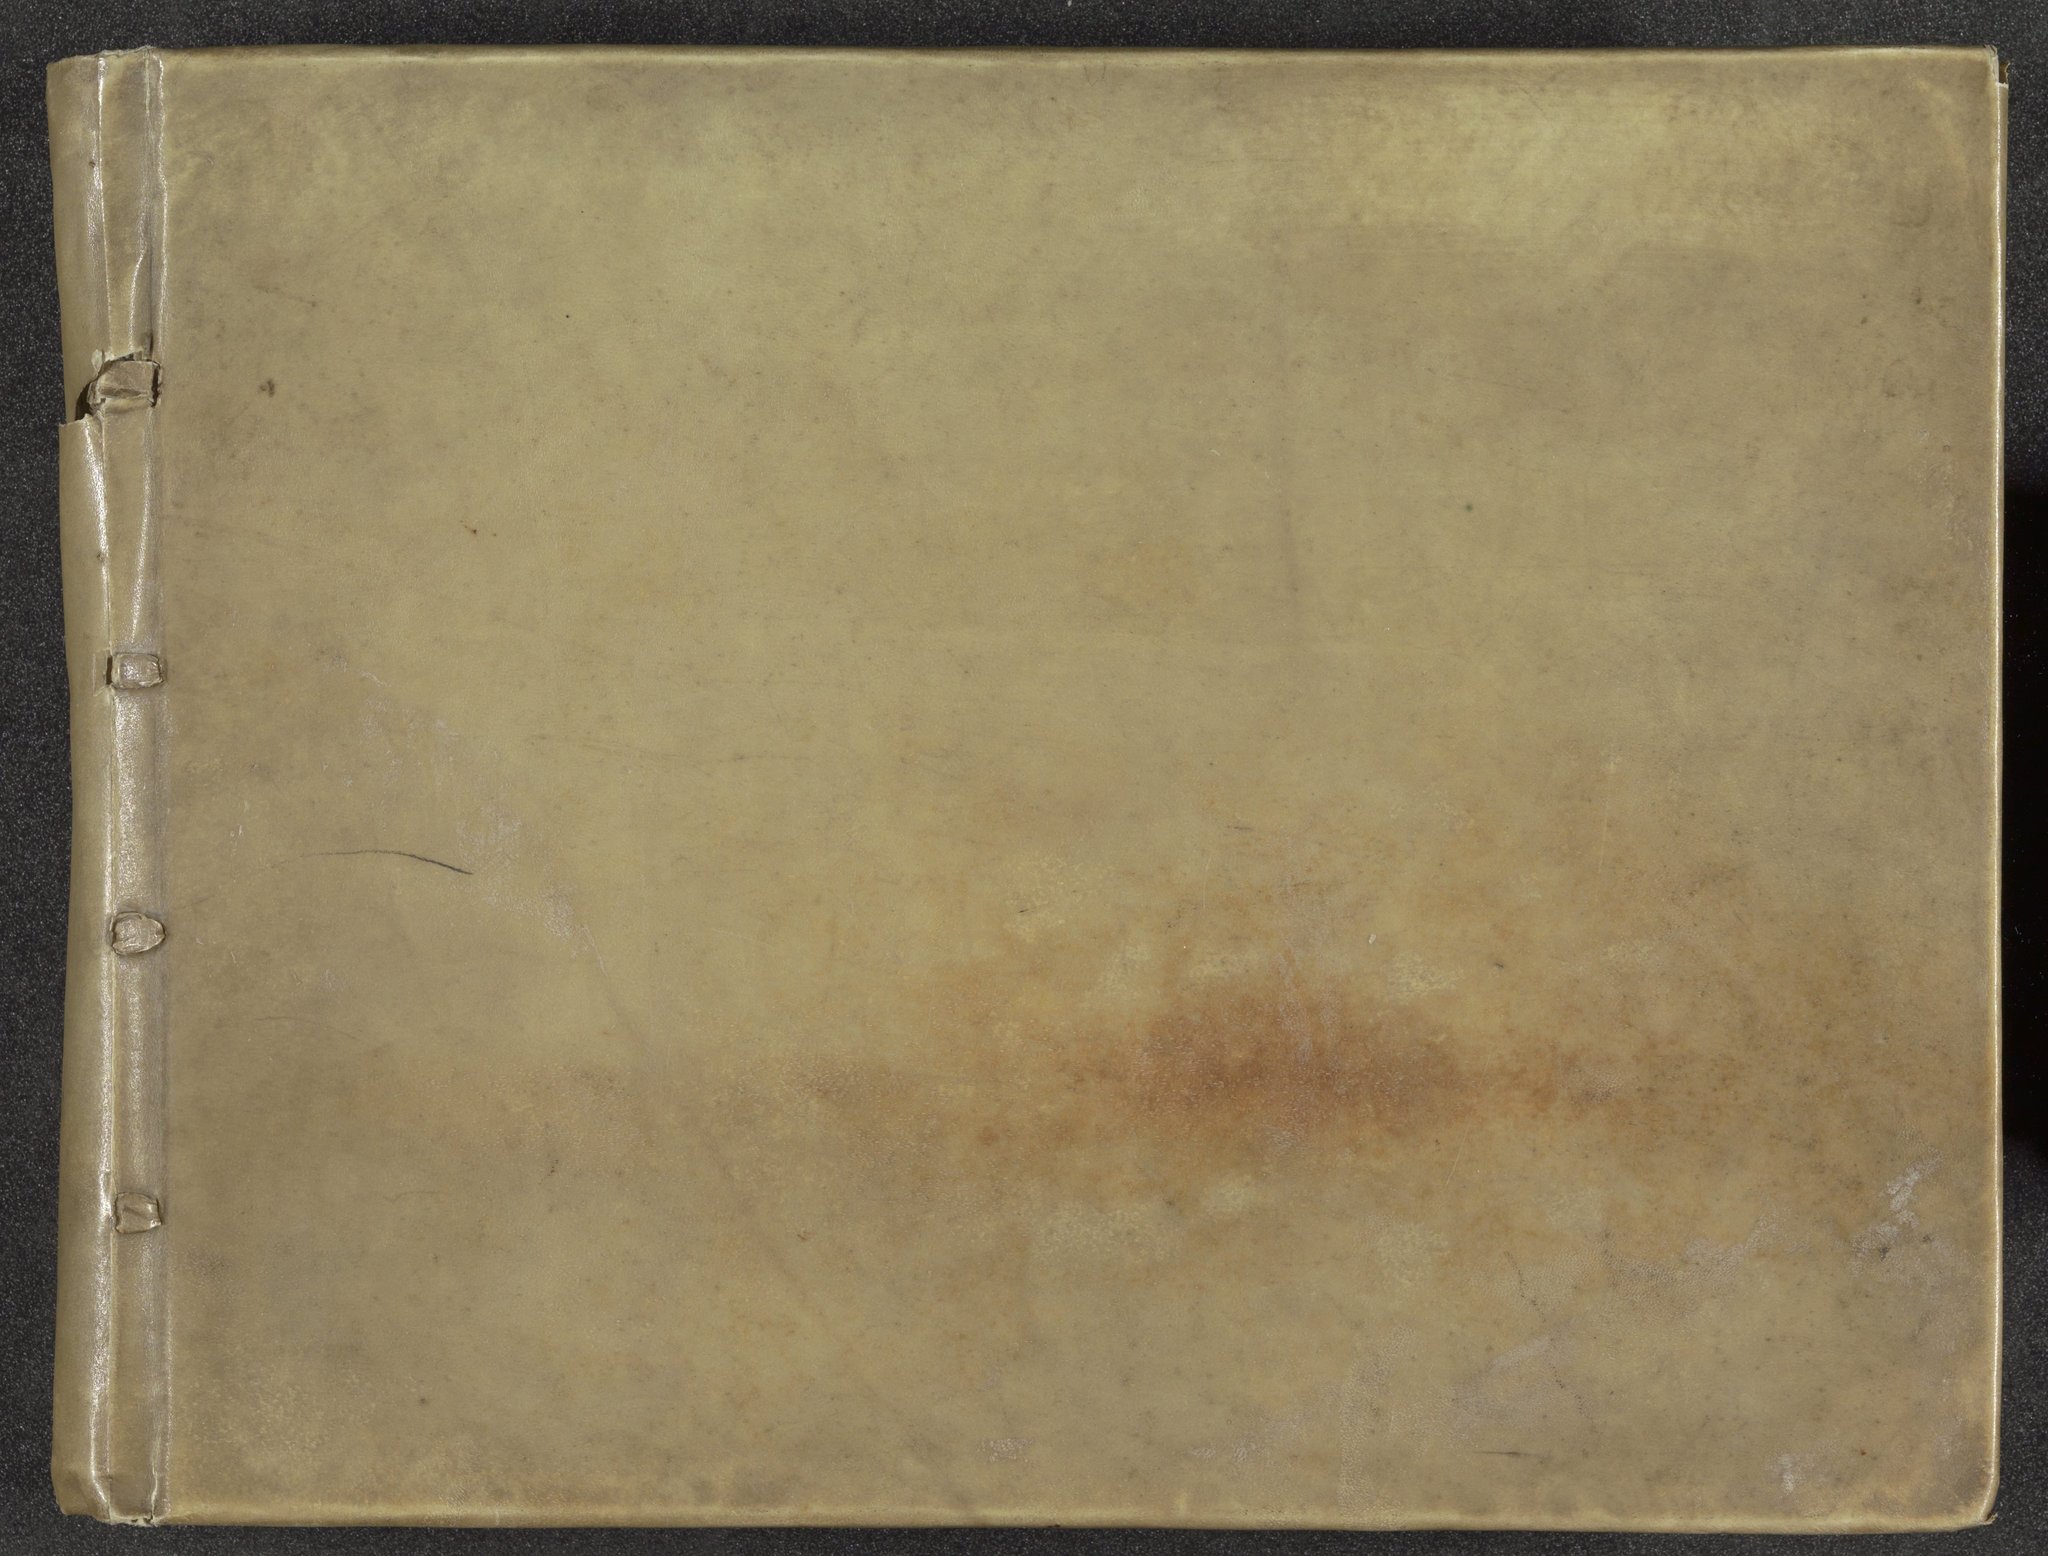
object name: prentrecueil, prentenalbum, prentalbum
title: Verzamelaarsalbum met houtsneden van Christoffel van Sichem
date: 1740-1808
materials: paper, parchment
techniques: bookbinding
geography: antwerp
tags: new testament, old testament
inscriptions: collector's mark: Lugt 2166, inscription: ‘15/ C. 10’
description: Verzamelaarsalbum met 750 opgeplakte houtsneden en 2 typografische titelpagina's op 135 blauwe albumbladen. Daarbij twee houtsneden los in het album. Het betreffen voornamelijk boekillustraties van Christoffel (II) en Christoffel (III) van Sichem, afkomstig uit publicaties van Jacob Pietersz Paets en Jan Klooster. Vooral bij Paets werden de houtsneden herhaaldelijk gebruikt en in verschillende contexten. De betekenis van meerdere voorstellingen in dit album is alleen af te leiden uit de plaats van de prent tussen de andere houtsneden. De houtsneden werden gesneden naar ontwerp van verschillende Nederlandse en Duitse prentmakers. Perkamenten band met achterin een los ovaal blauw blad.